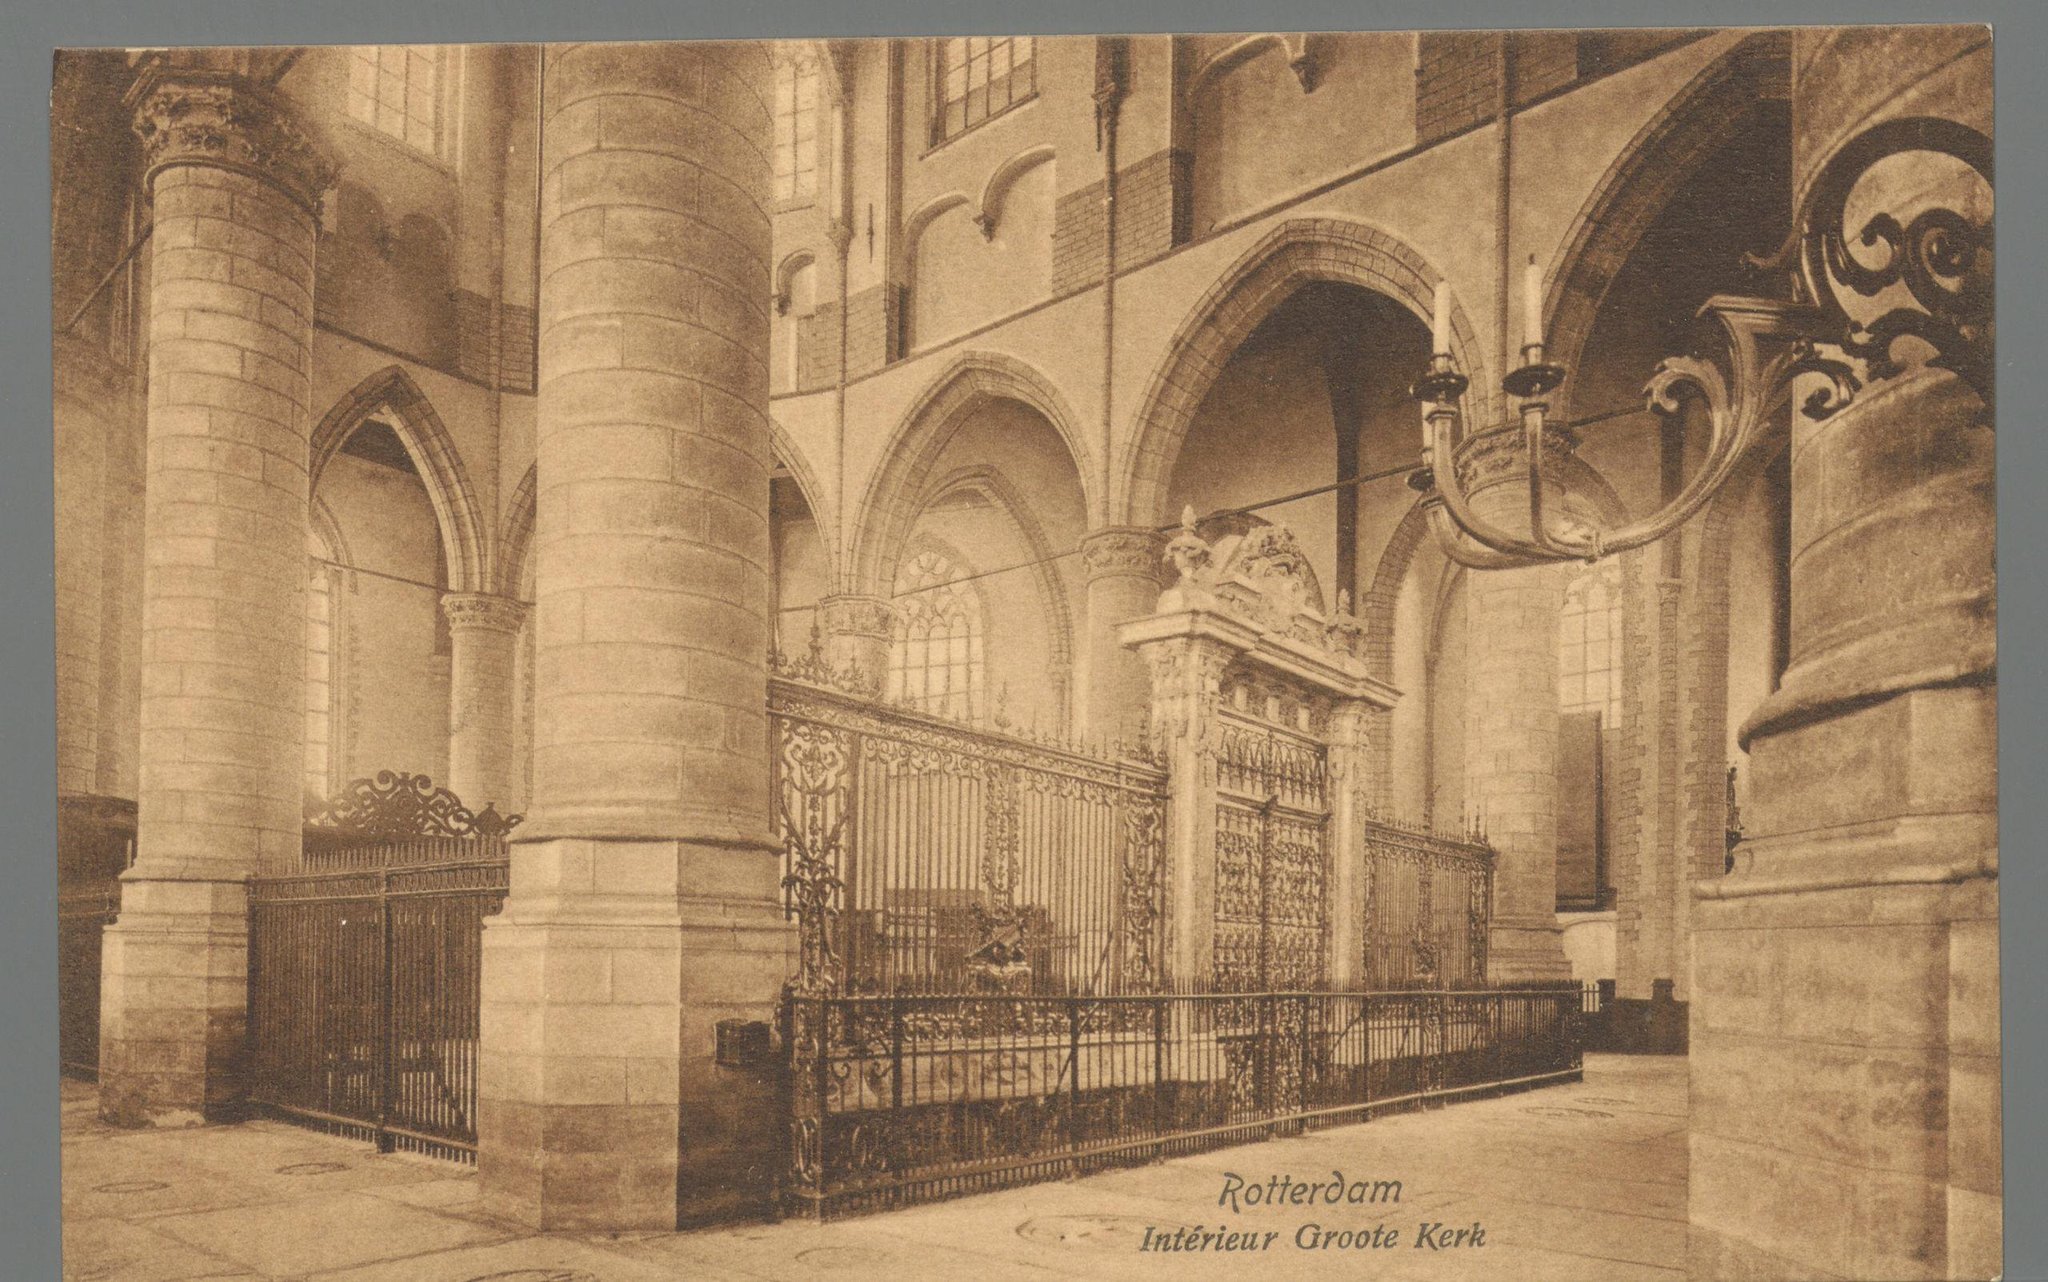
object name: ansichtkaart, prentbriefkaart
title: Rotterdam. Intérieur Groote Kerk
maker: Anonymous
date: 1912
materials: cardboard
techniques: photograph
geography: leipzig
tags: interior of church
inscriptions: date